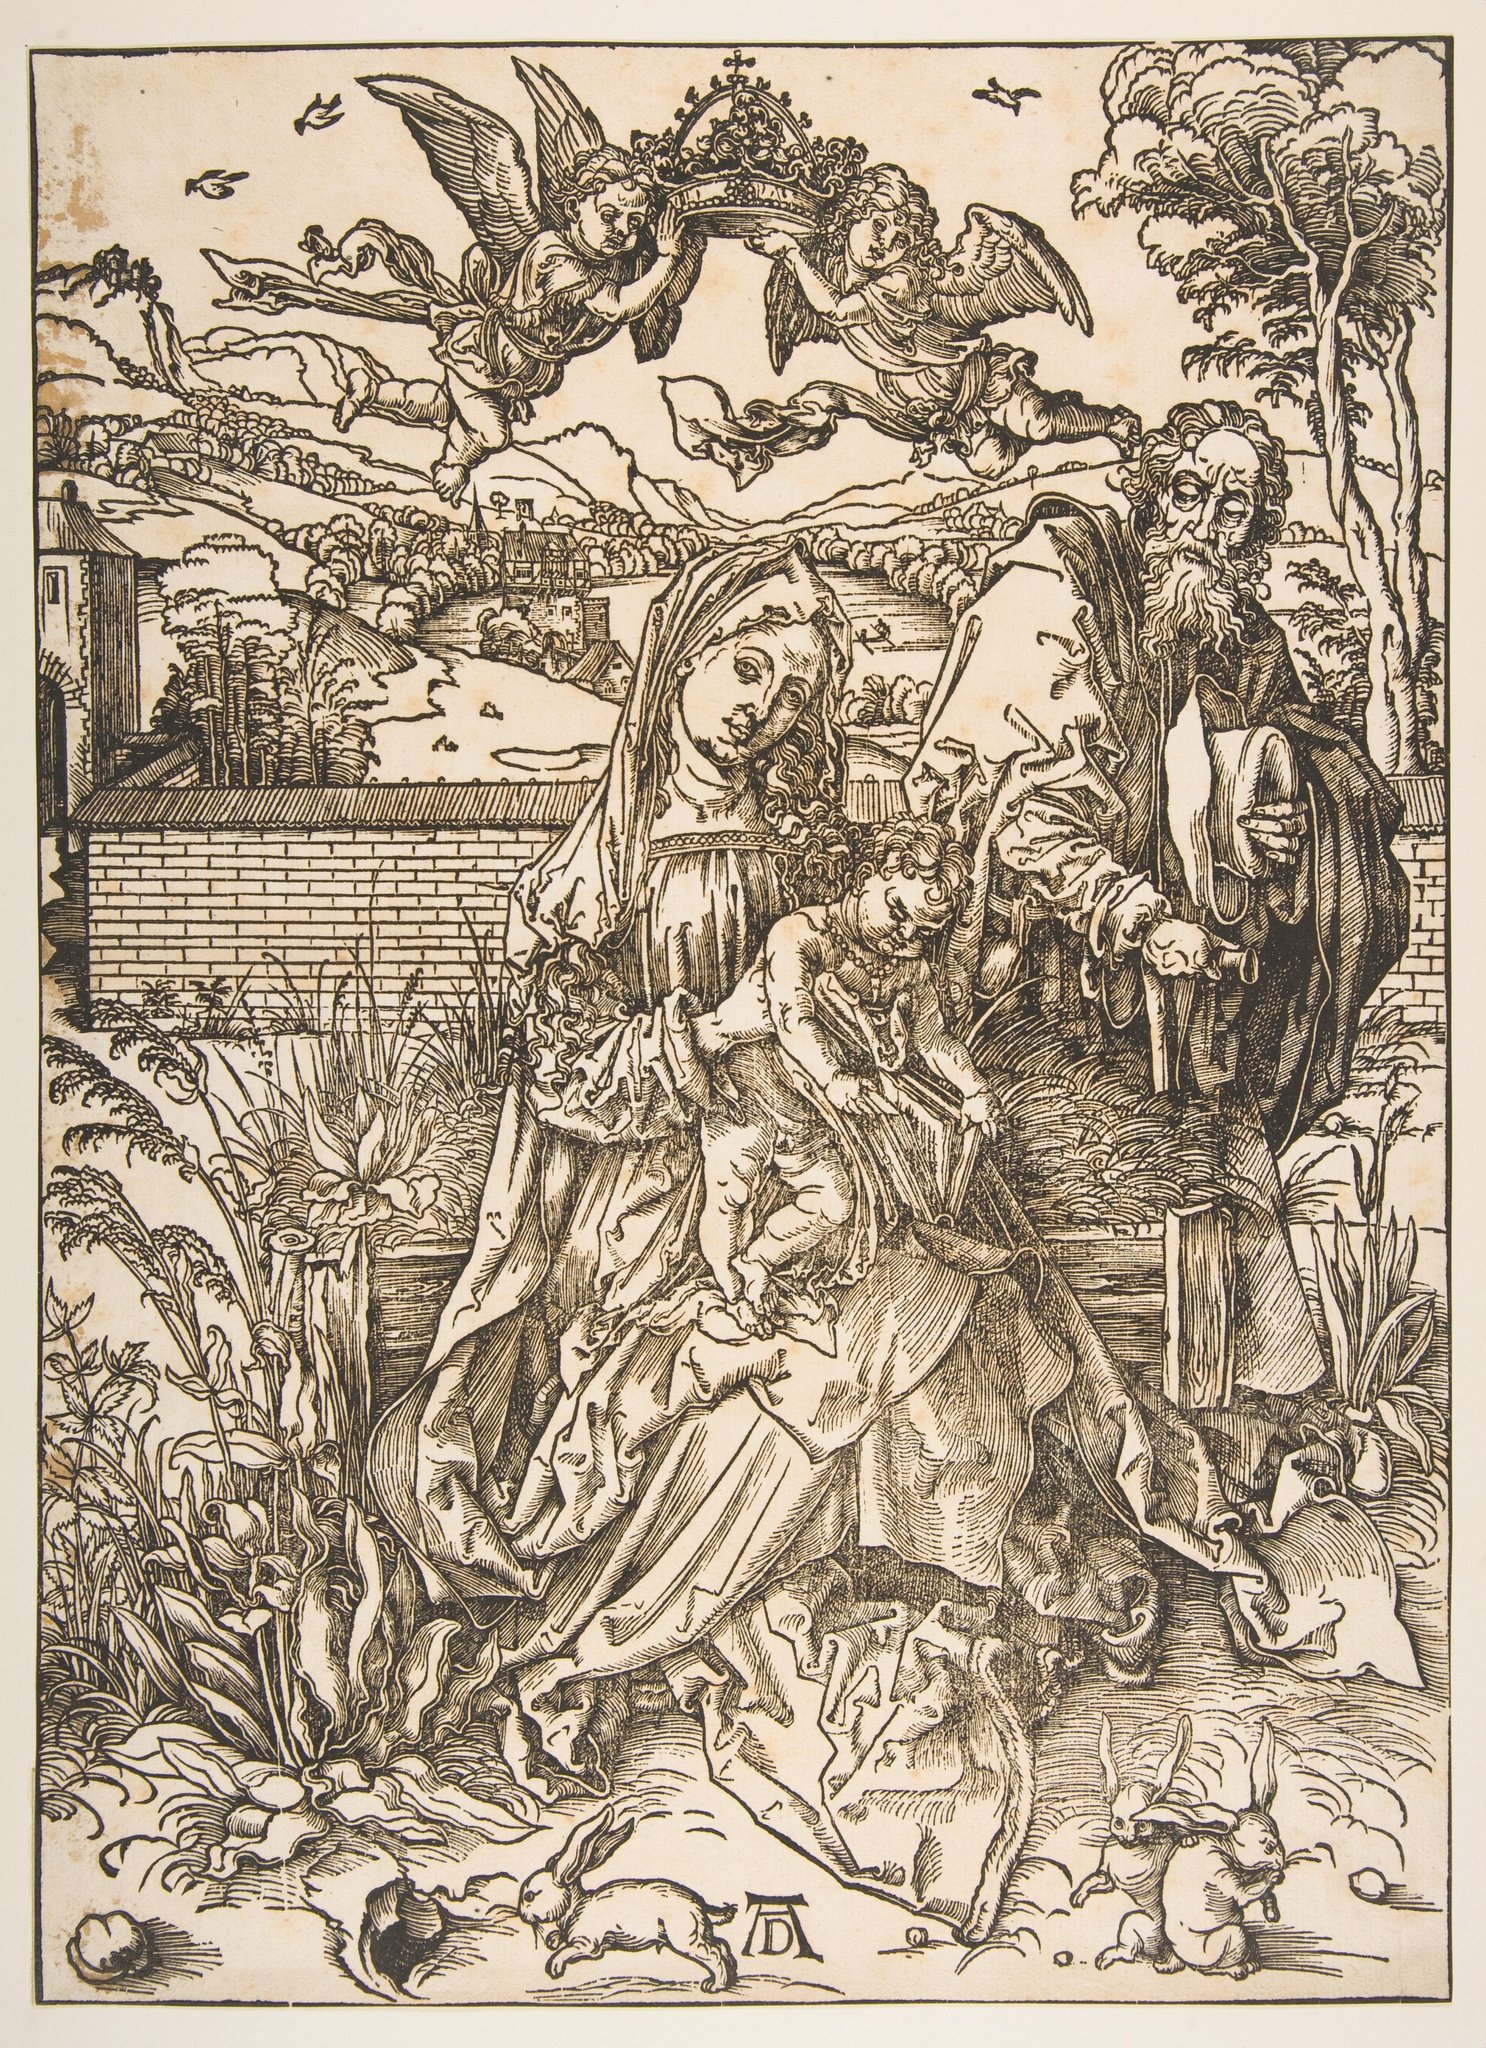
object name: print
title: The Holy Family with the Three Hares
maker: albrecht dürer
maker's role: artist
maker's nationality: german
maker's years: 1471-1528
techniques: woodcut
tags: putti,rabbits,holy family